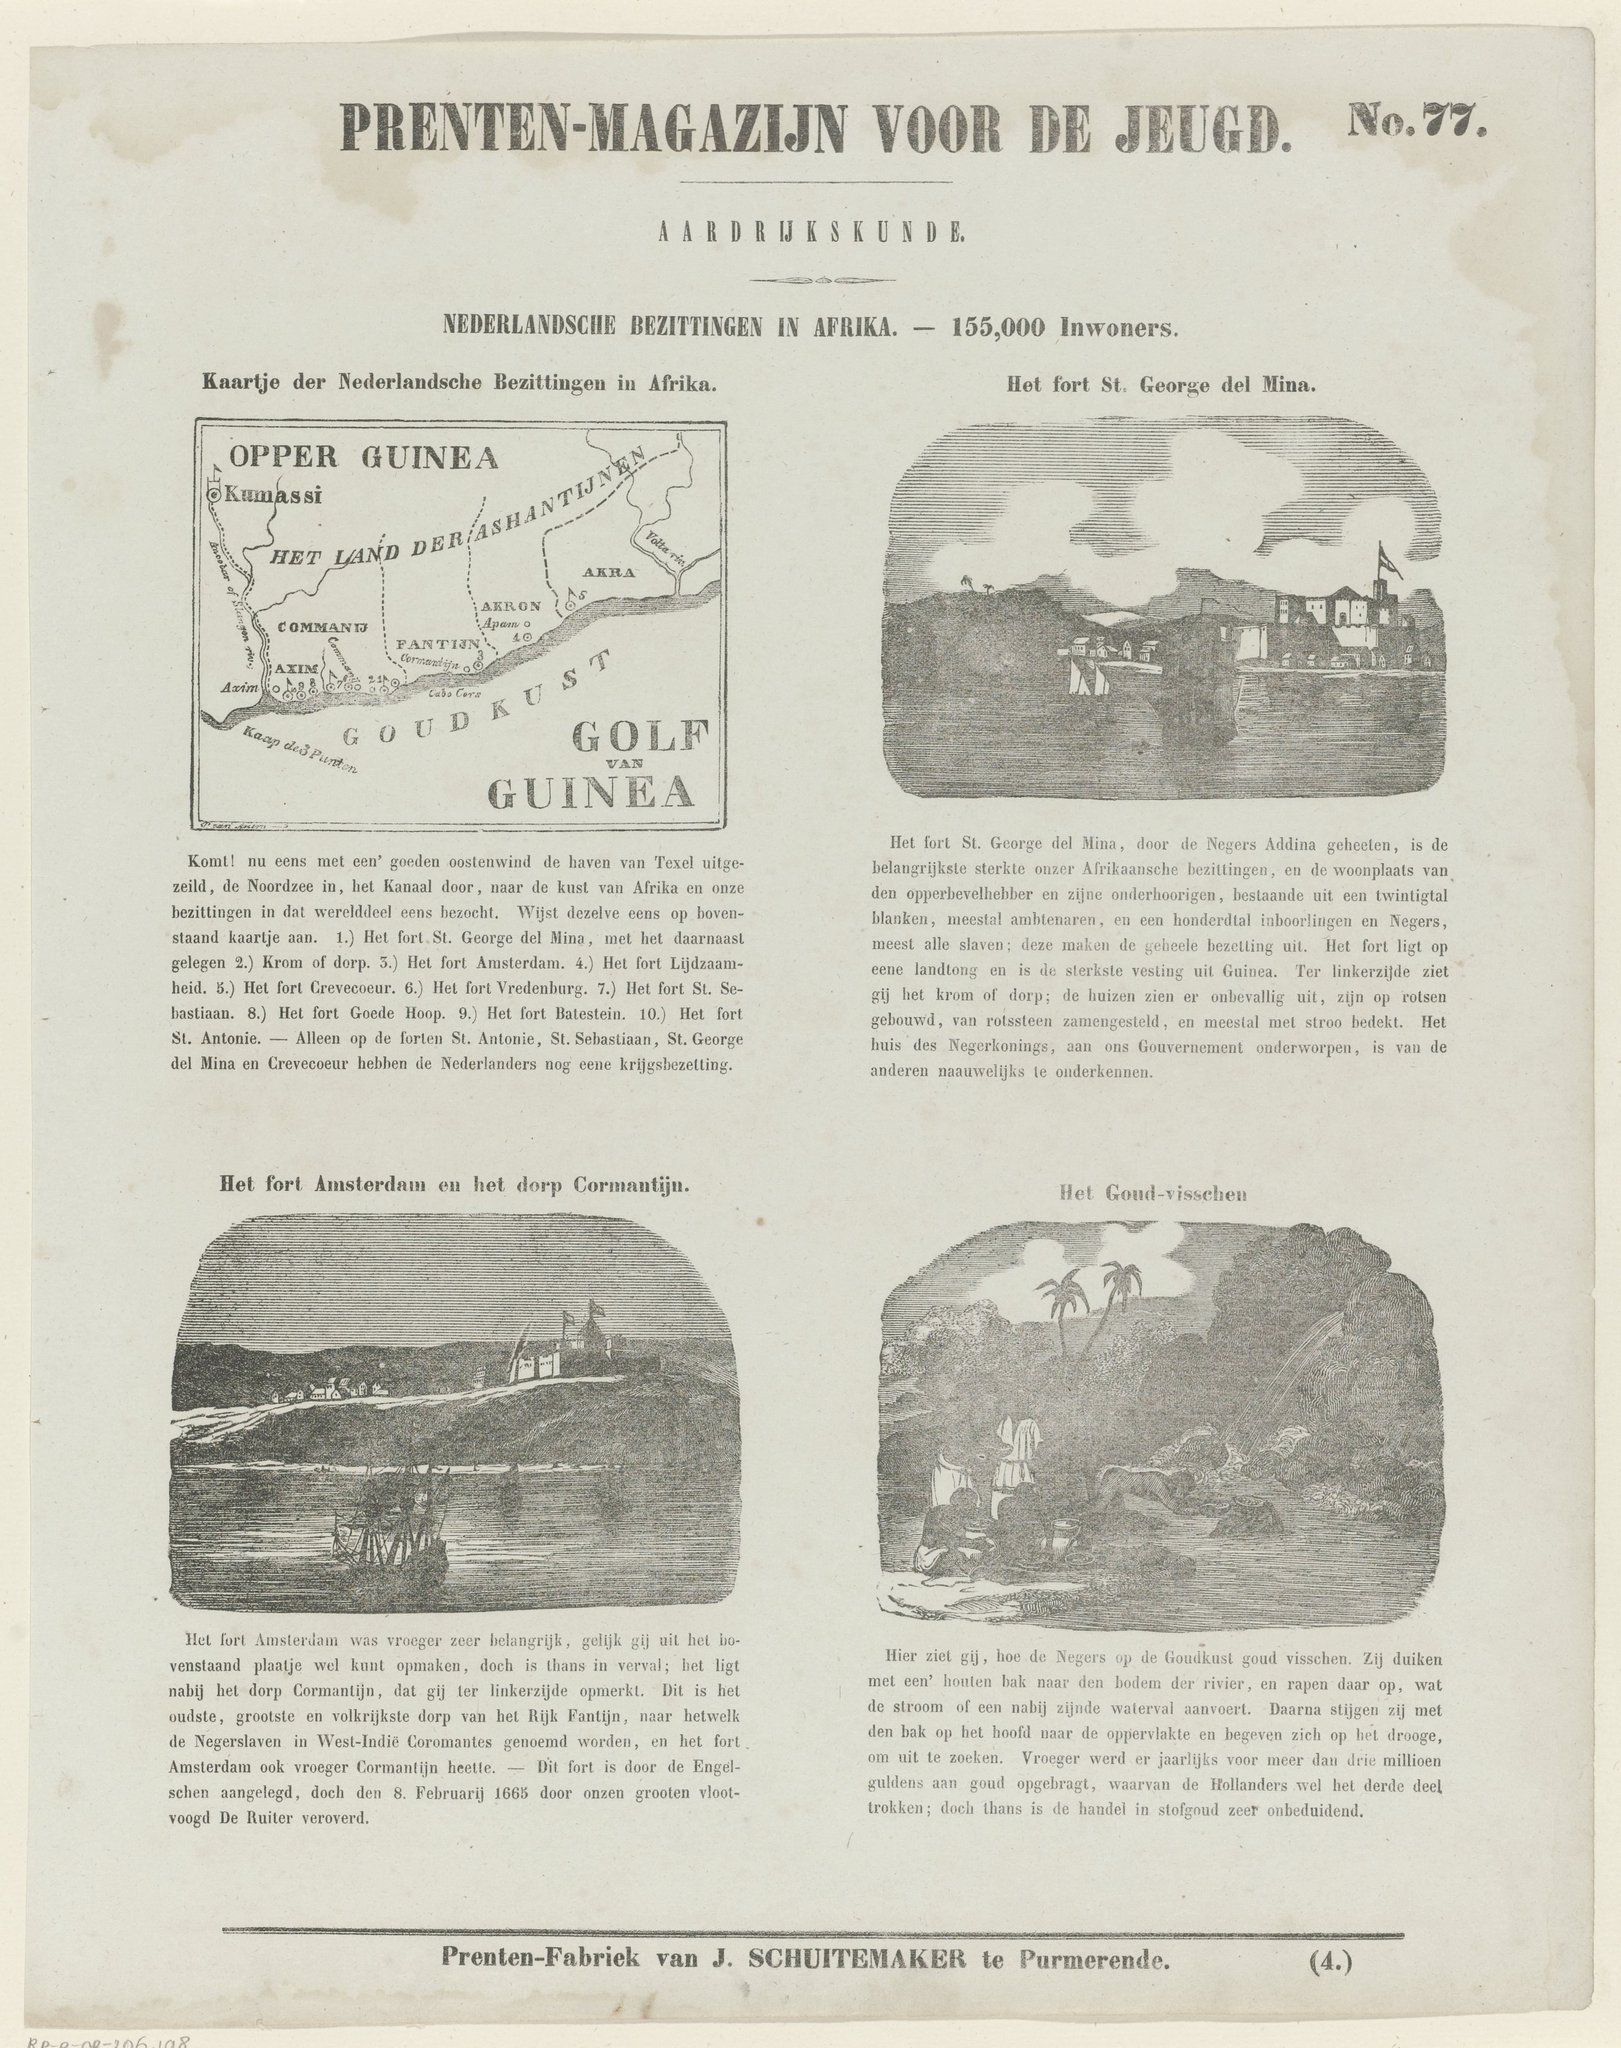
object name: print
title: Nederlandsche bezittingen in Afrika. - 155,000 inwoners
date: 1850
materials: paper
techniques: letterpress printing, engraving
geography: purmerend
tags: colonial system, (map of) africa, ford, maps, atlases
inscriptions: collector's mark: Lugt 2760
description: Na voltooiing van de acht jaargangen van de reeks 'Prenten-magazijn voor de jeugd' in 1850 heeft Jan Schuitemaker al deze prenten heruitgegeven en omgenummerd als nr. 1 t/m 192. De oorspronkelijke jaargang wordt telkens nog vermeld rechtsonder op de prent. Binnen de jaargangen zijn prenten van hetzelfde thema in clusters van vier achter elkaar gezet.